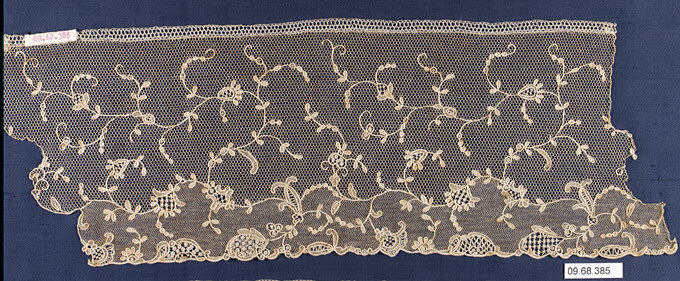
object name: fragment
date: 1801-1900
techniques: lace